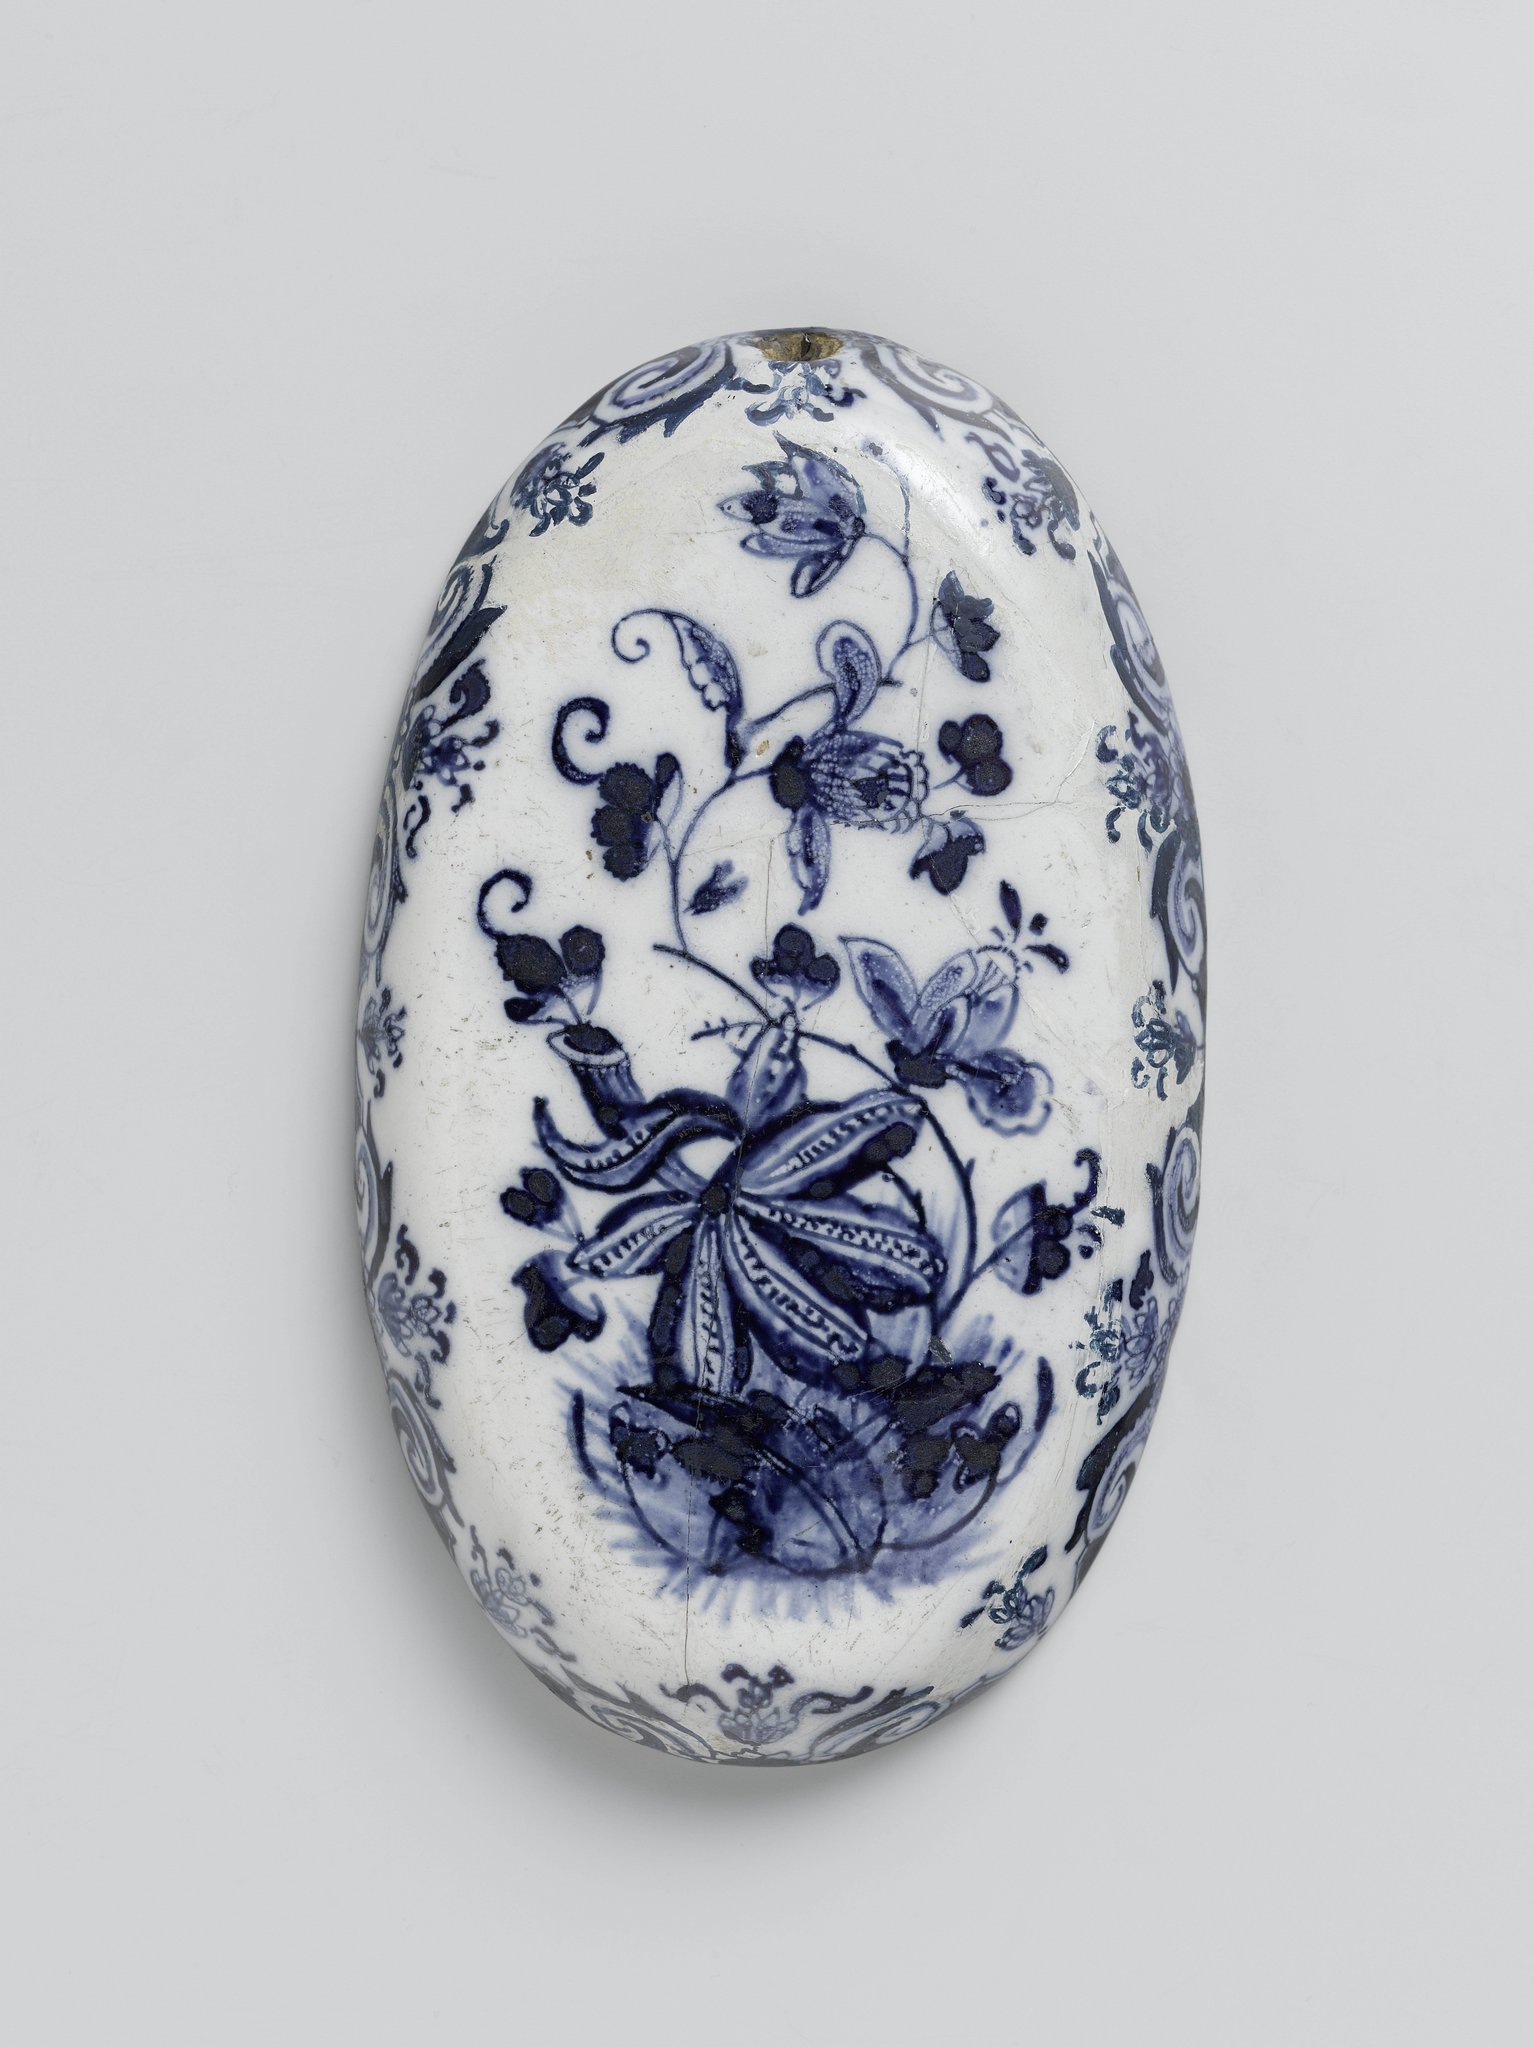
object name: borstelrug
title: Ovale borstelrug van faïence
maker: Anonymous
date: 1725-1750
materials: earthenware, glaze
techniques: painted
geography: delft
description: Ovale borstelrug van blauw beschilderde faïence, beschilderd met bladeren en bloemenranken en langs de rand een bloemmotief. De borstelrug is sinds 1958 in bruikleen afgestaan aan J.H. Loudon (Aerdenhout) en in maart 1996 geretourneerd.